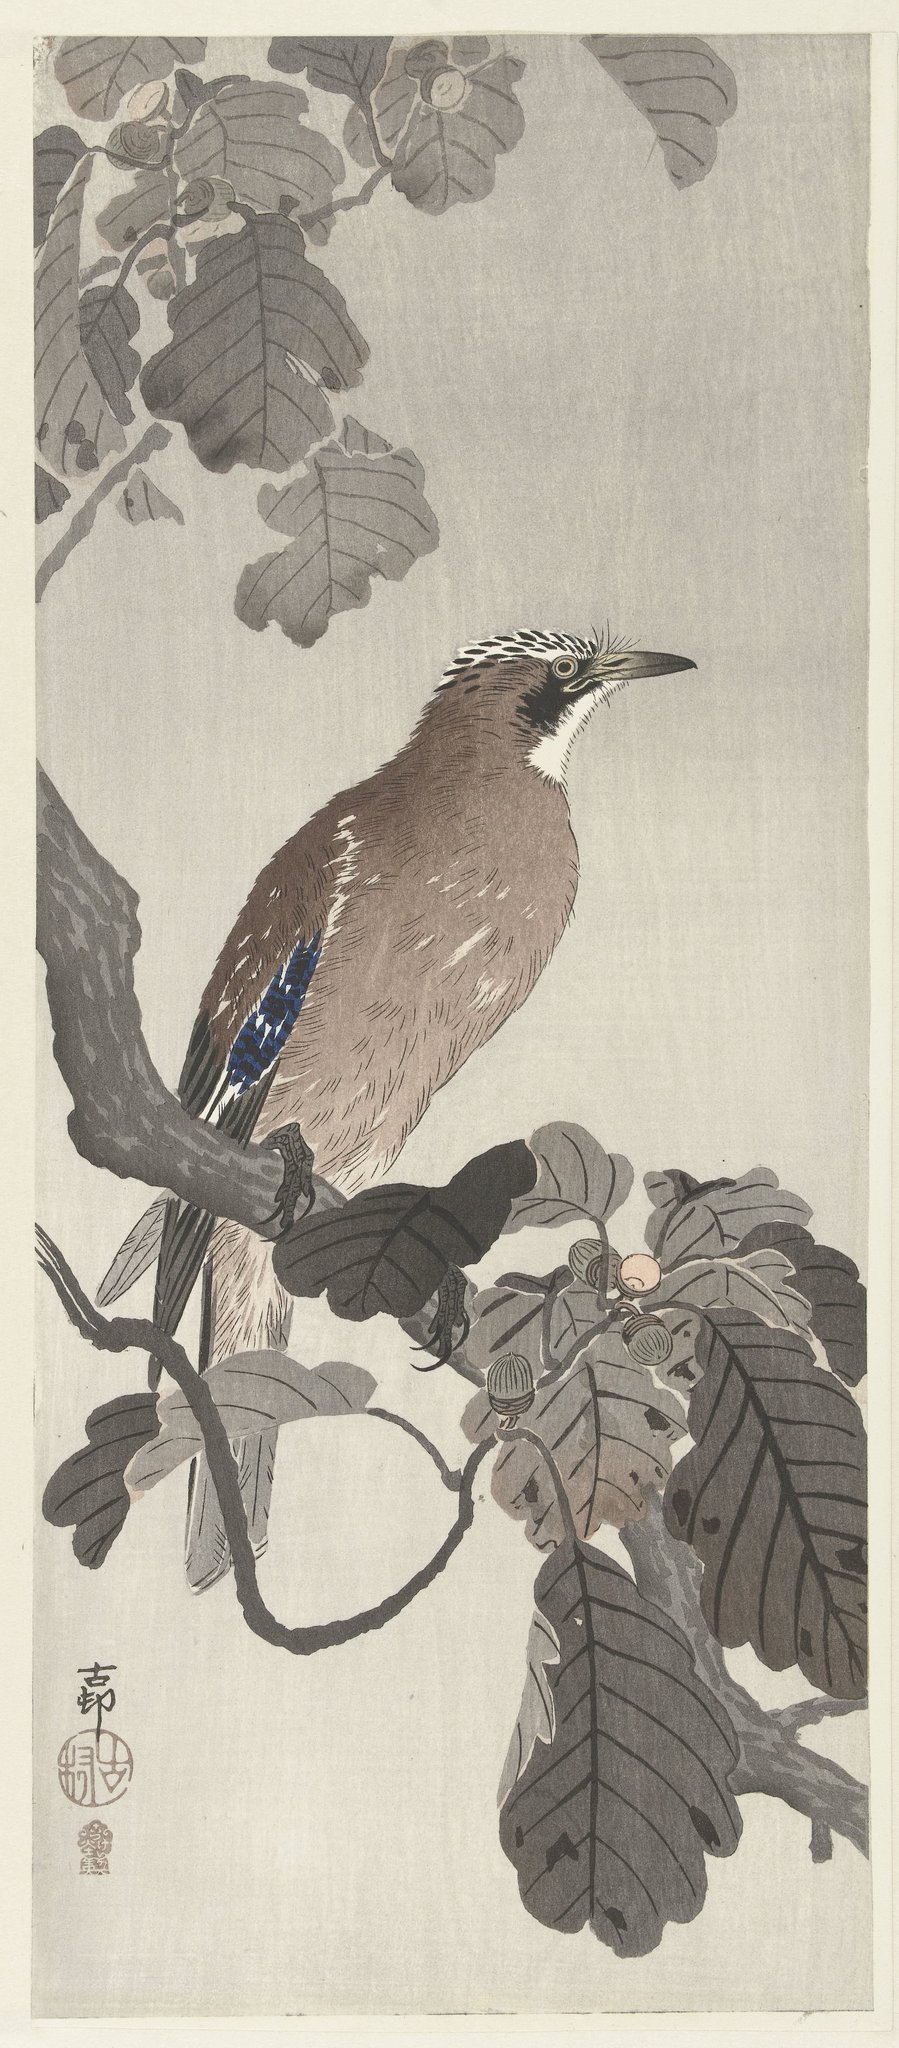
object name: print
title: Vlaamse gaai op boomtak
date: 1900-1910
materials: paper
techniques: woodcut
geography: tokyo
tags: plants; vegetation, song-birds: jay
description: Vlaamse gaai, naar rechts, zittend op tak van eik.